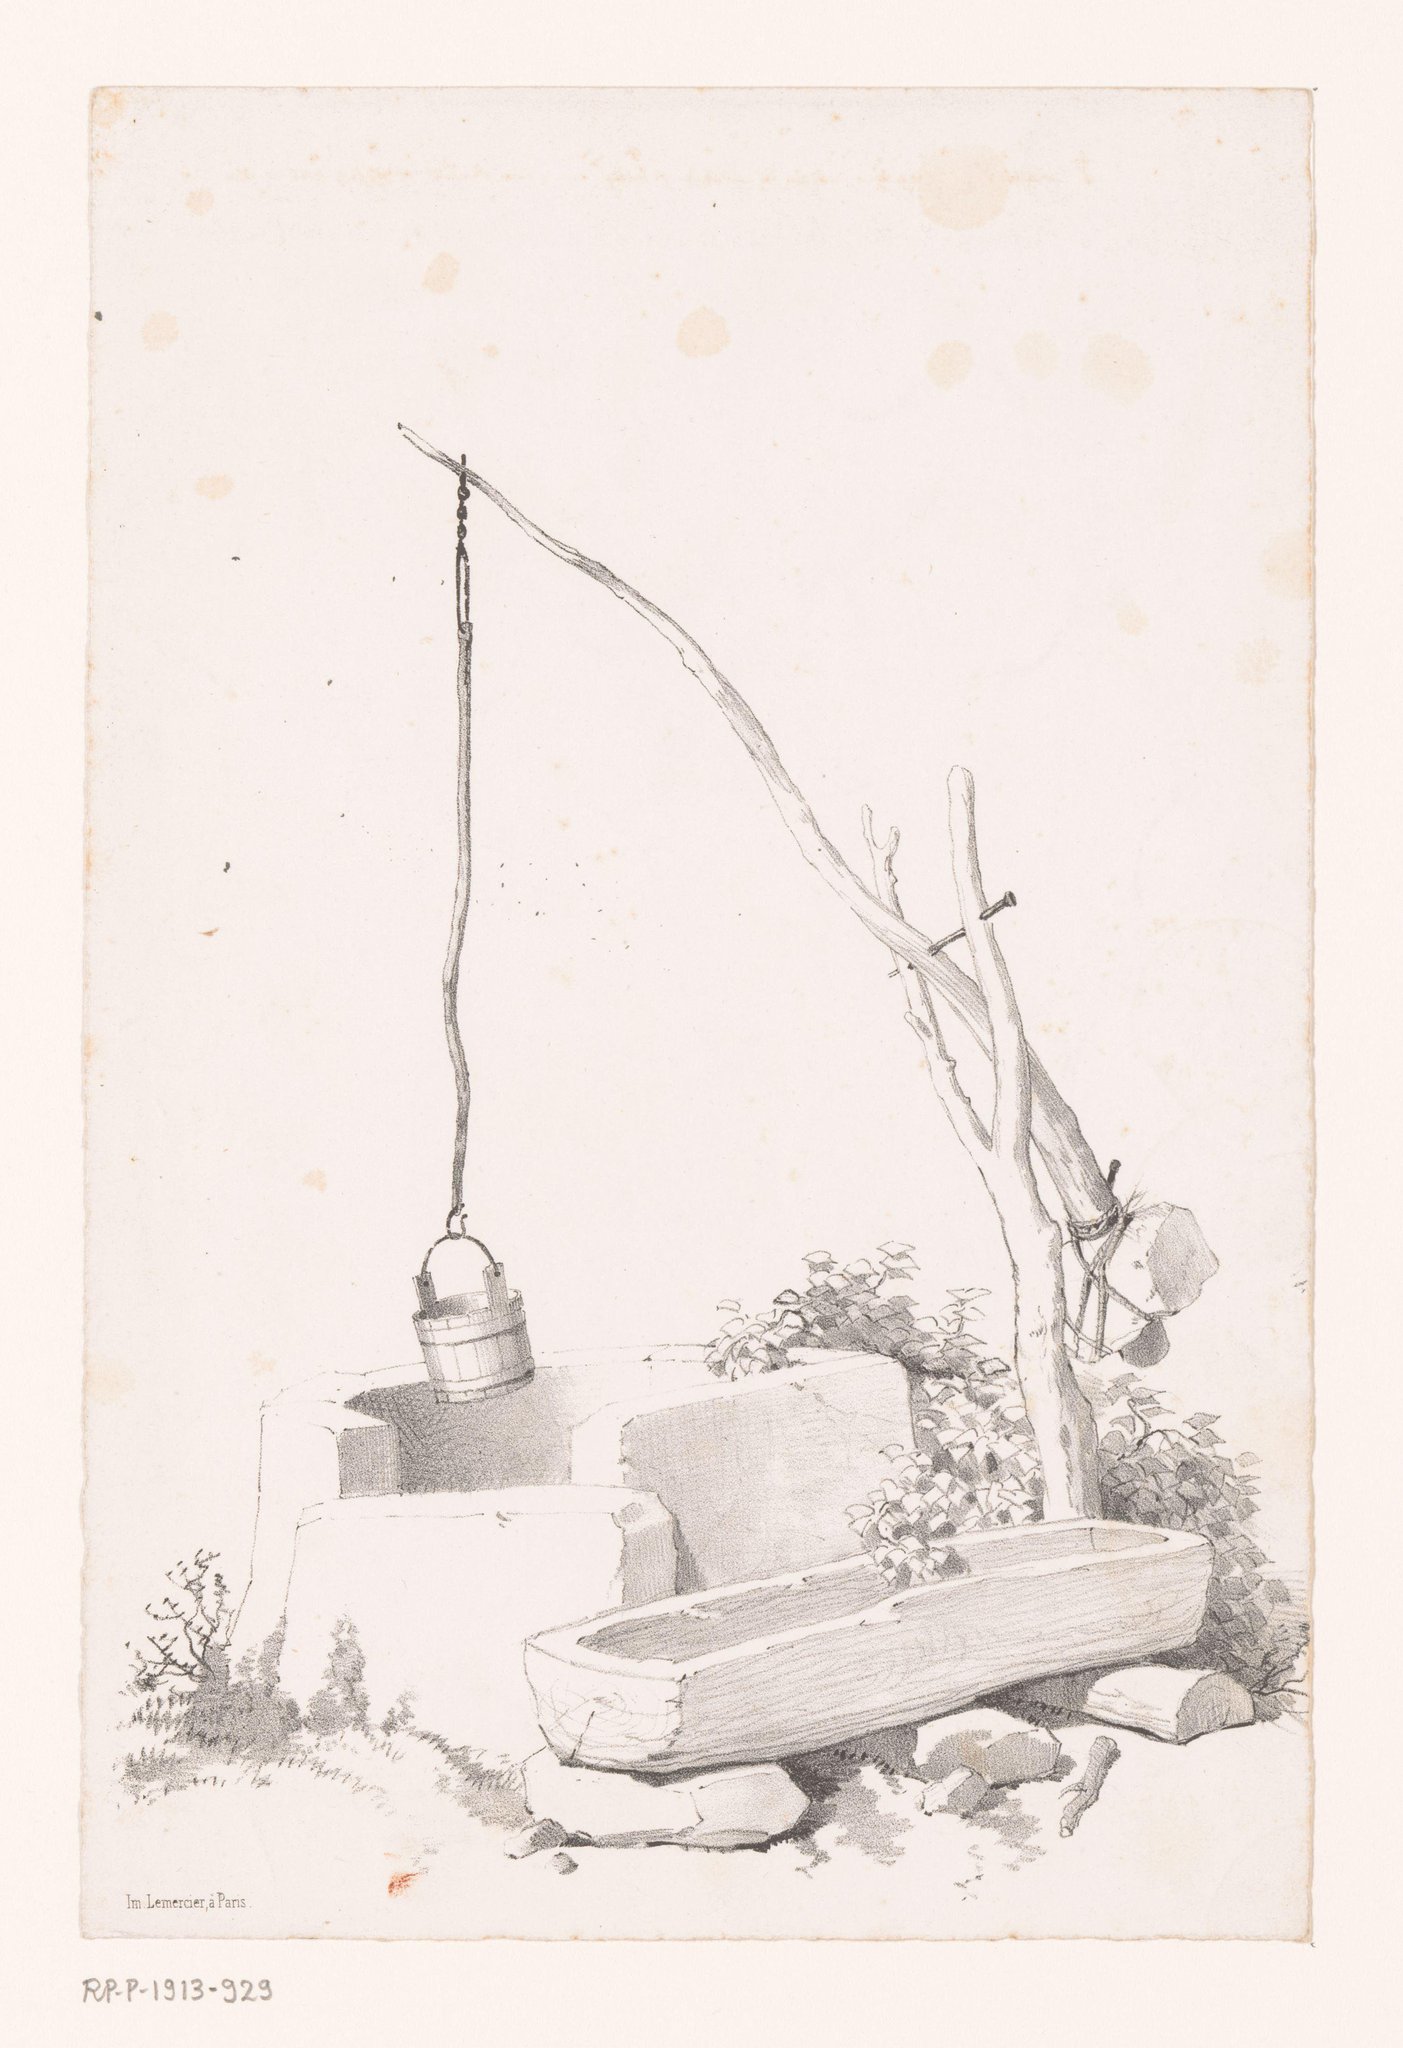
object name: print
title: Waterput met emmer en drinkbak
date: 1829-1875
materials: paper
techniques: lithograph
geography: paris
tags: trough, well, wooden container: barrel, cask, bucket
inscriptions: collector's mark: Lugt 2228a